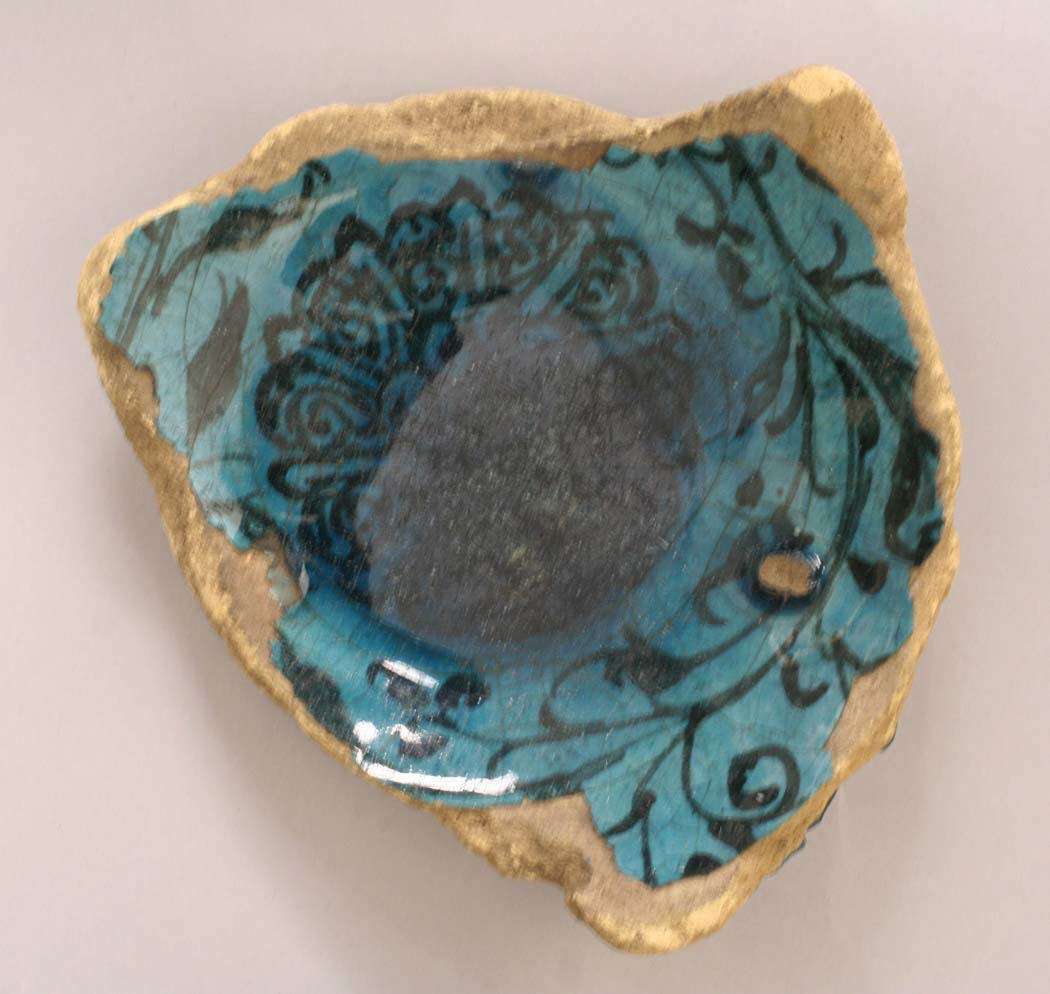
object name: ceramic fragment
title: Fragment of a Bowl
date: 1301-1400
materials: earthenware, glaze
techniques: painting, underglaze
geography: egypt or syria